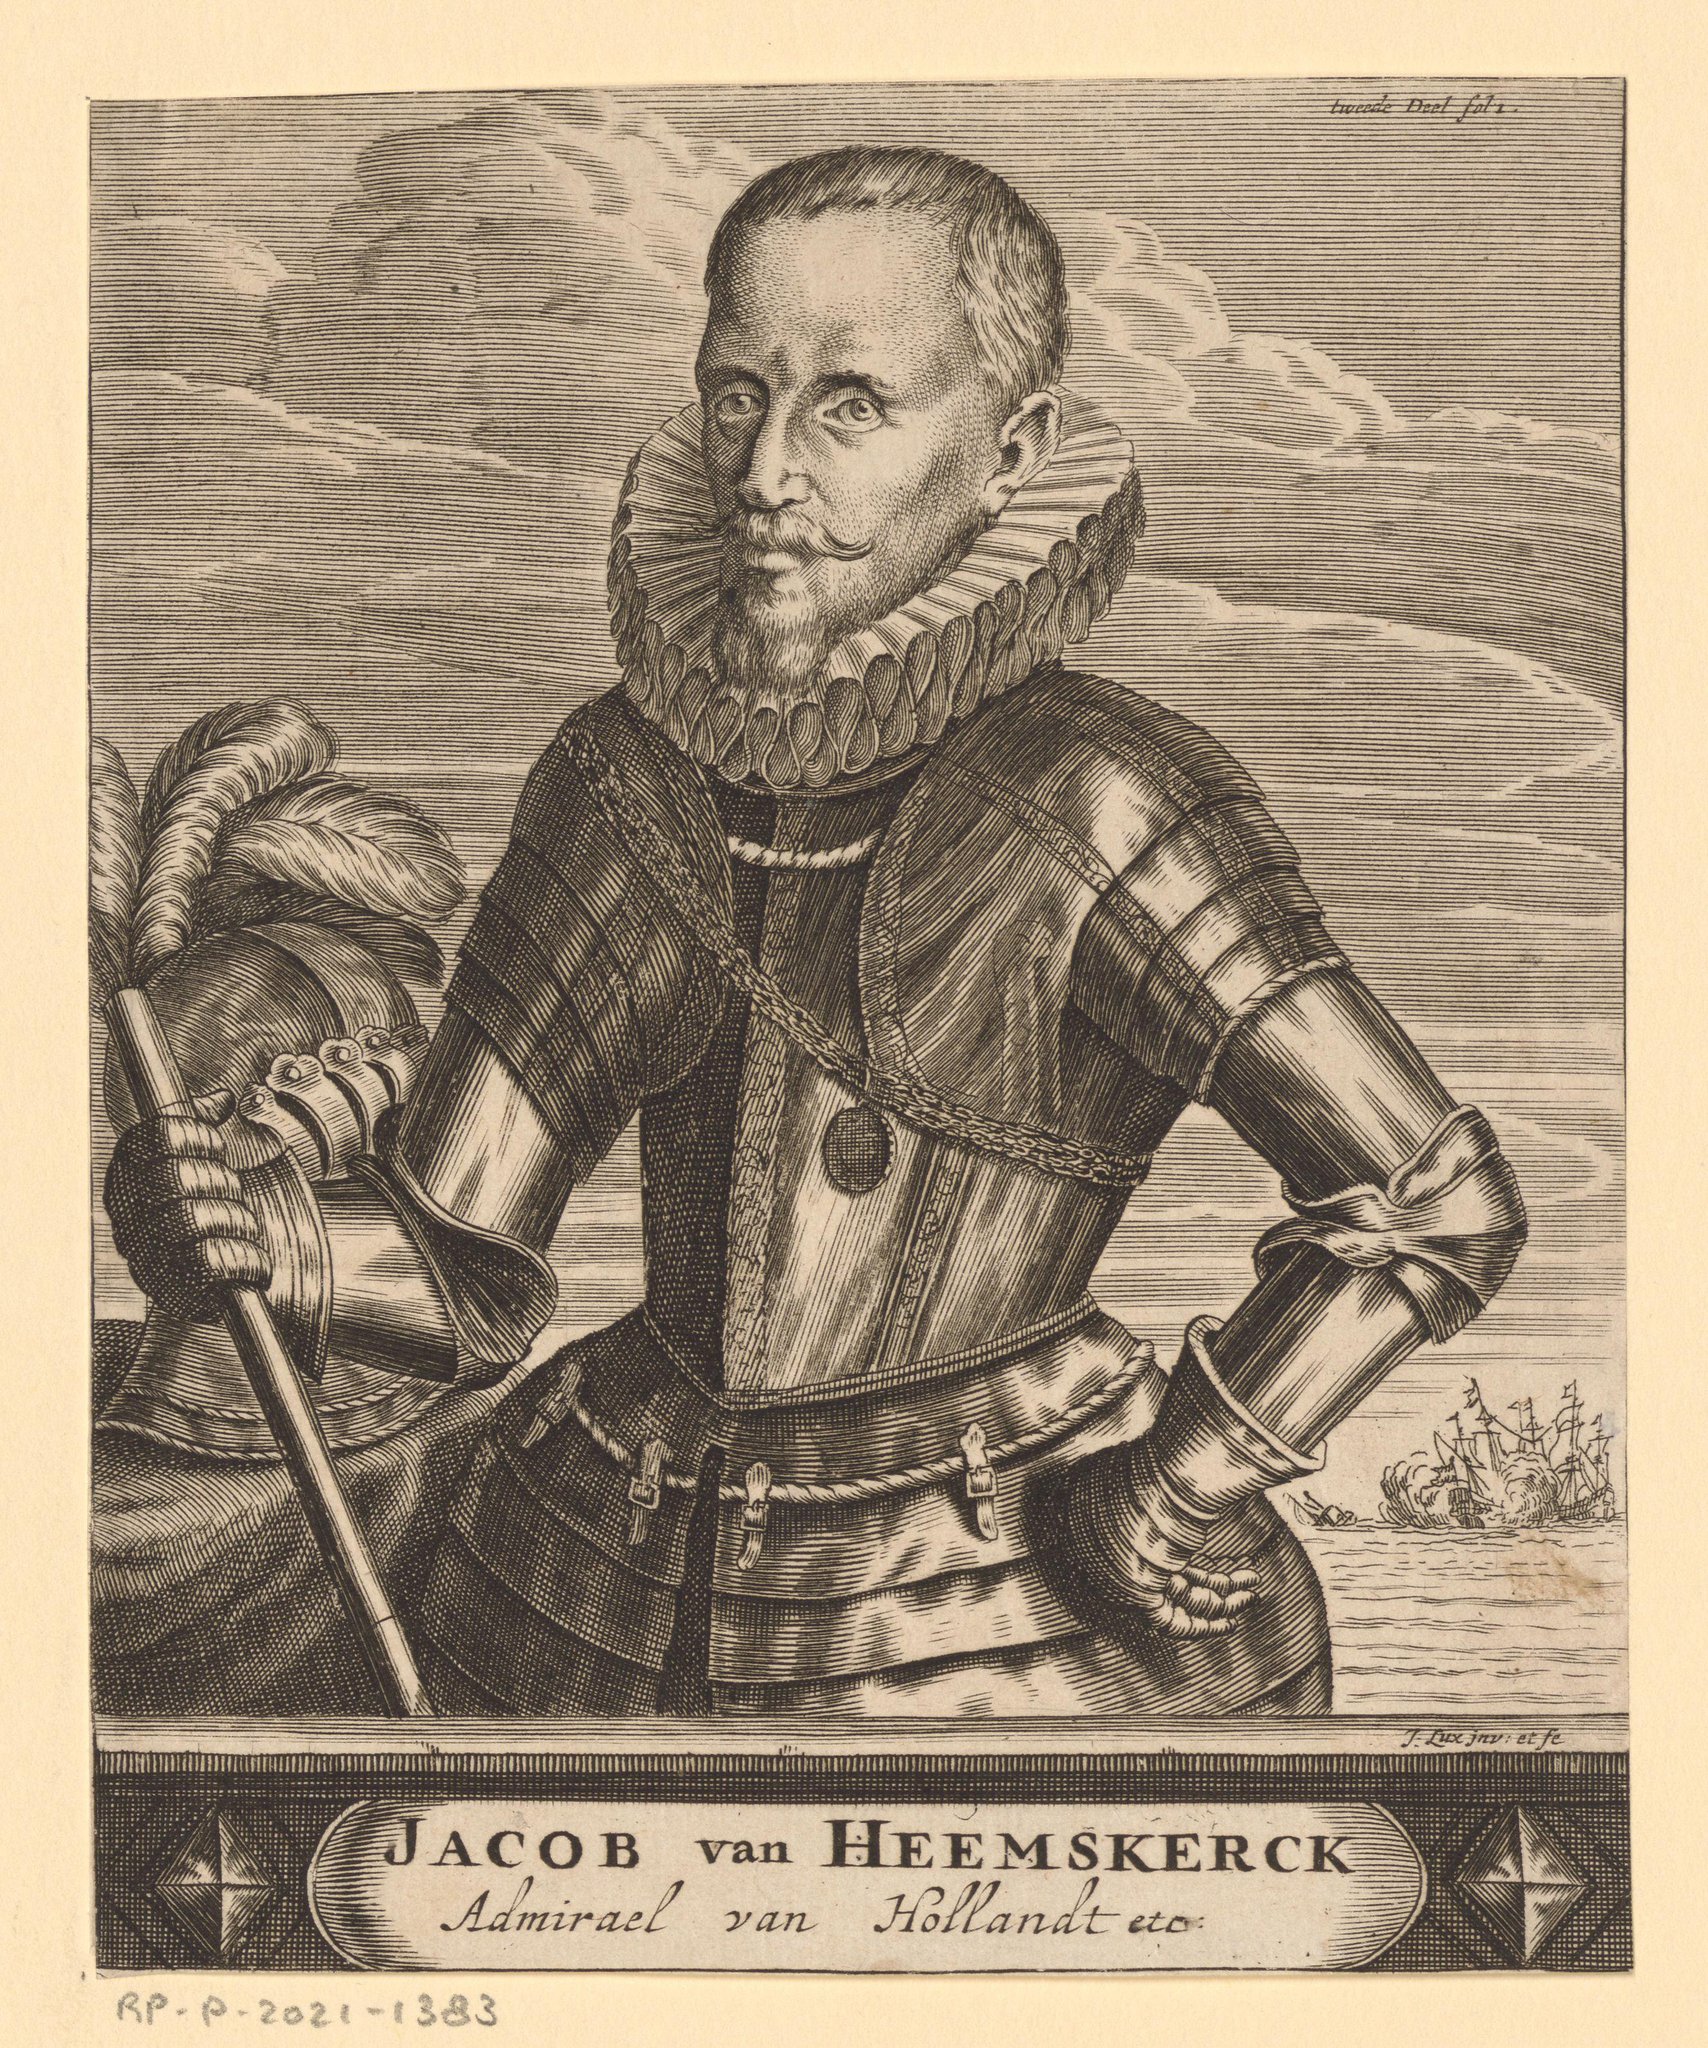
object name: print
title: Portret van Jacob van Heemskerck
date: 1676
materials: paper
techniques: engraving, etching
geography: amsterdam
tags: amsterdam, jacob van heemskerck, helmet, armour, battle (+ naval force), historical persons, baton of general, commander-in-chief, admiral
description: Prent uit: Bos, Lambert van den. Leeven en daden der doorluchtighste zee-helden. Amsterdam: Jan Claesz. ten Hoorn en Jan Bouman, 1676. Andere staat gebruikt in de 1683-editie van dit werk.